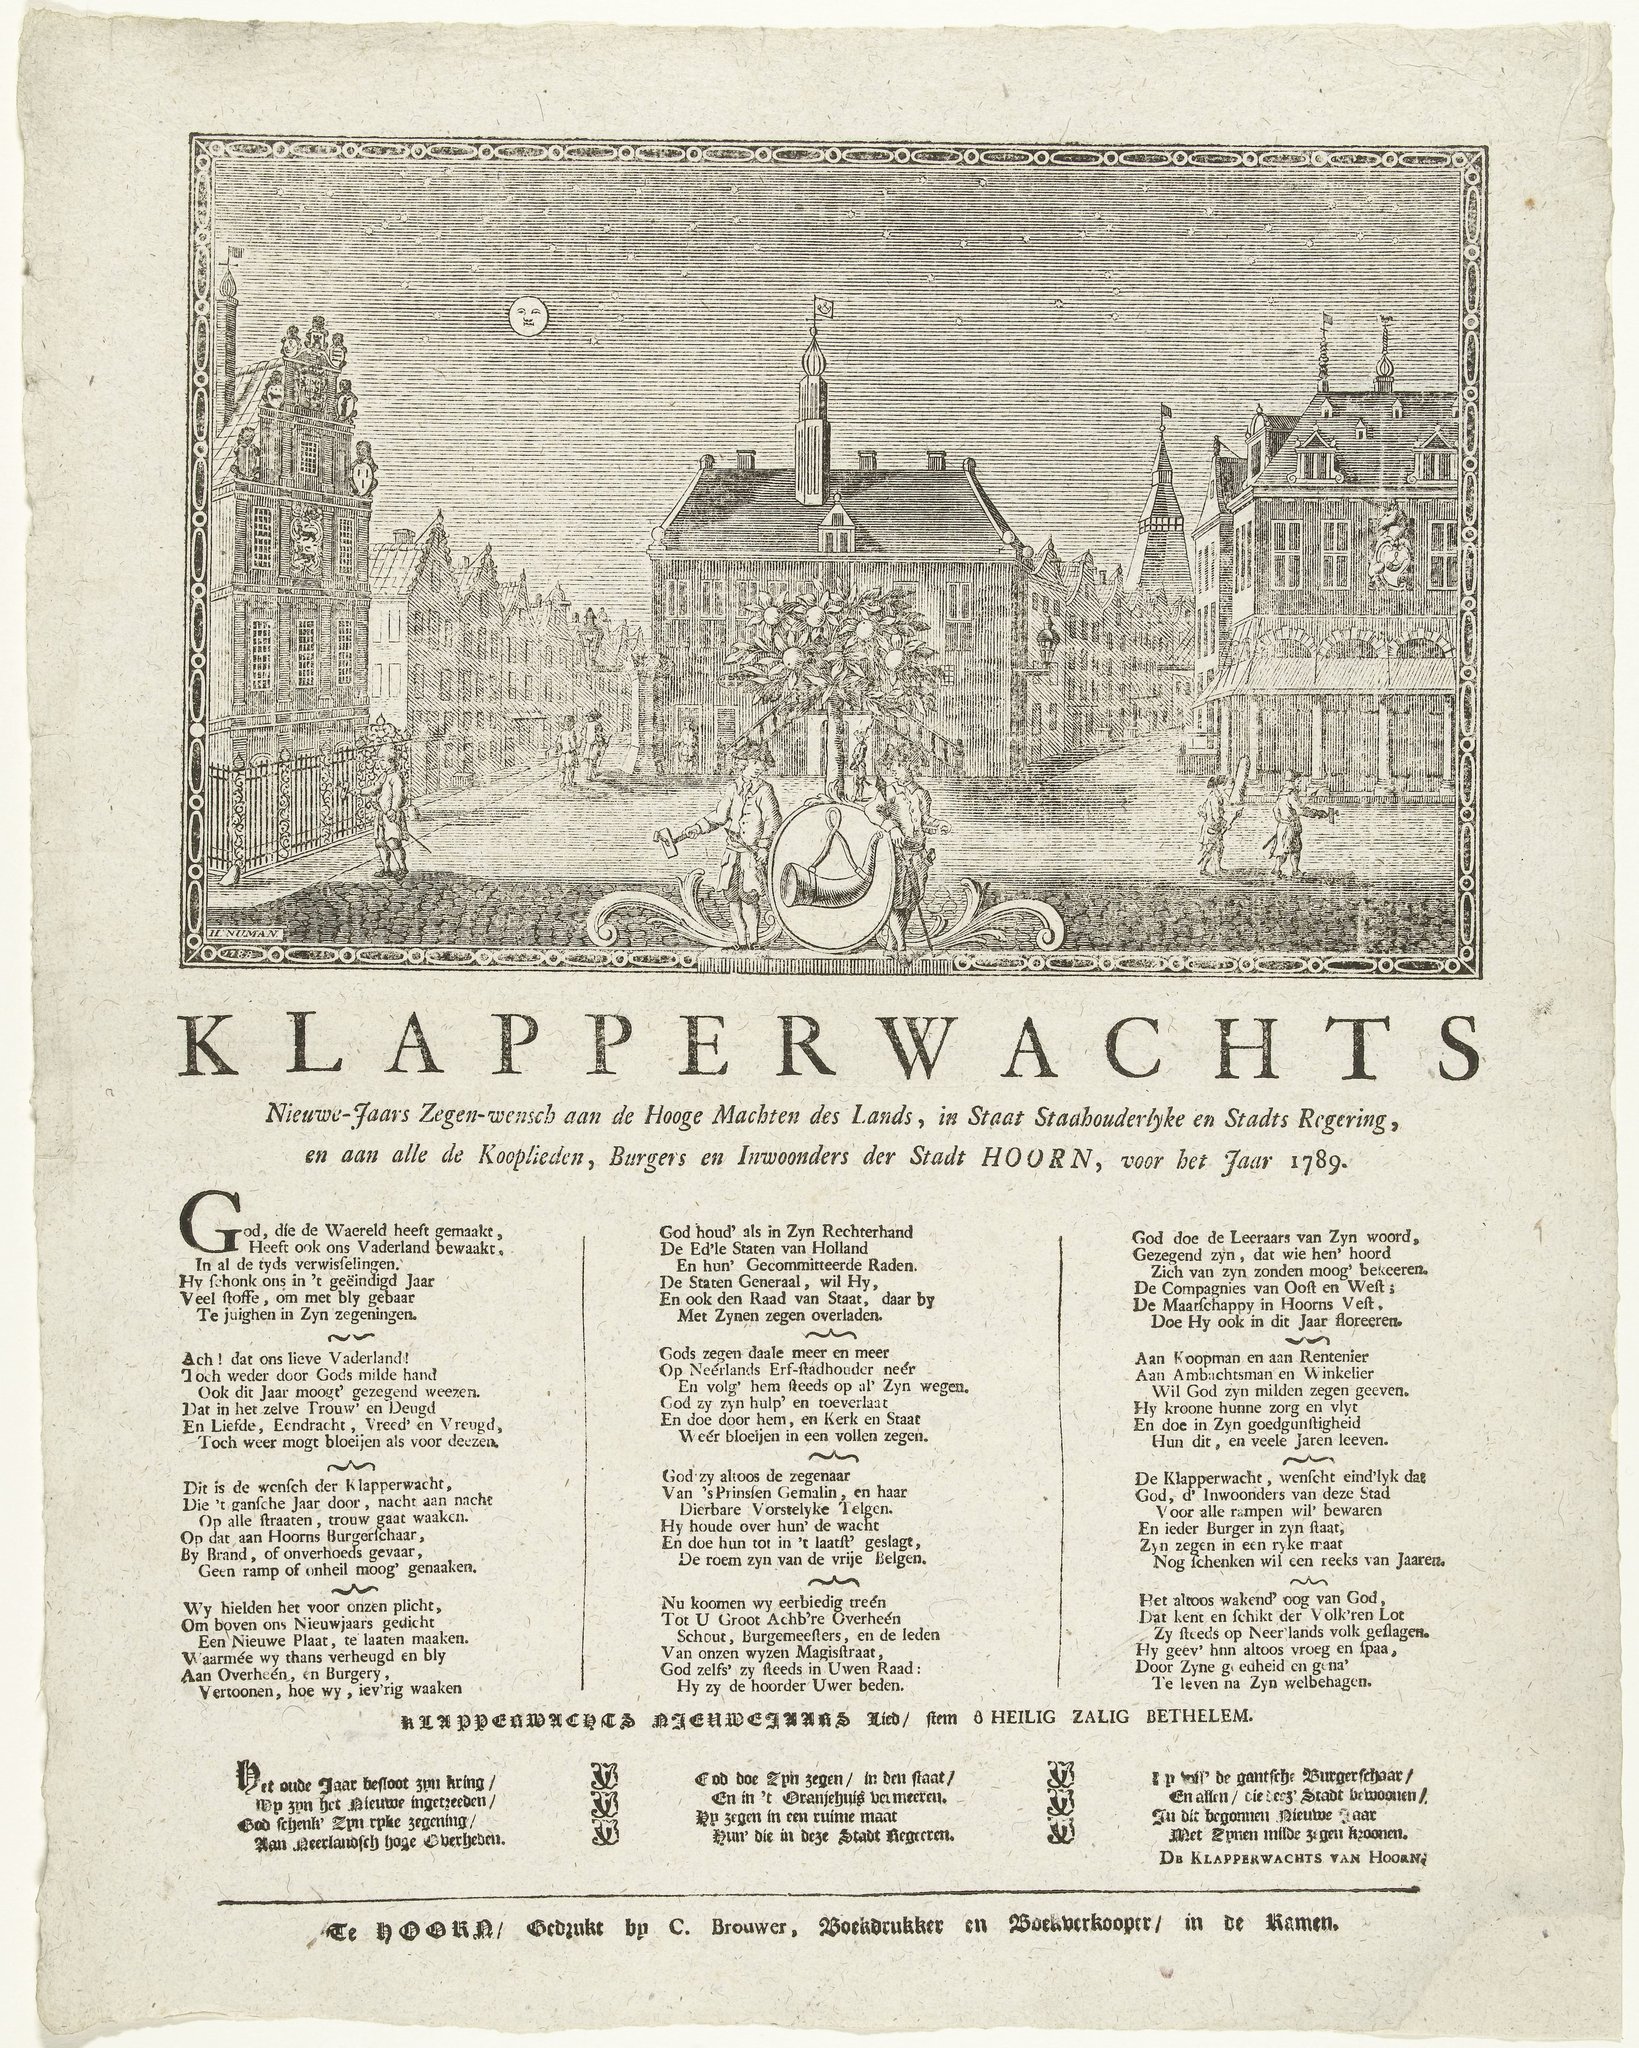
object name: print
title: Nieuwjaarsprent van de Hoornse klapperwacht voor het jaar 1789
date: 1788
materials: paper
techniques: letterpress printing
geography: hoorn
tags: night patrol, hoorn (north holland)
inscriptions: collector's mark: Lugt 2228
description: Nieuwjaarsprent van de klapperwacht (nachtwacht) van de stad Hoorn voor het jaar 1789. Opgedragen aan de bestuurders en inwoners van Hoorn. Twee leden van de wacht staande bij een Oranjeboom met het wapen van Hoorn, op de achtergrond het plein de Roode Steen te Hoorn met het oude stadhuis, de Waag en het Statencollege. Op het blad onder de voorstelling een vers in drie kolommen met onderaan een lied in drie kolommen.